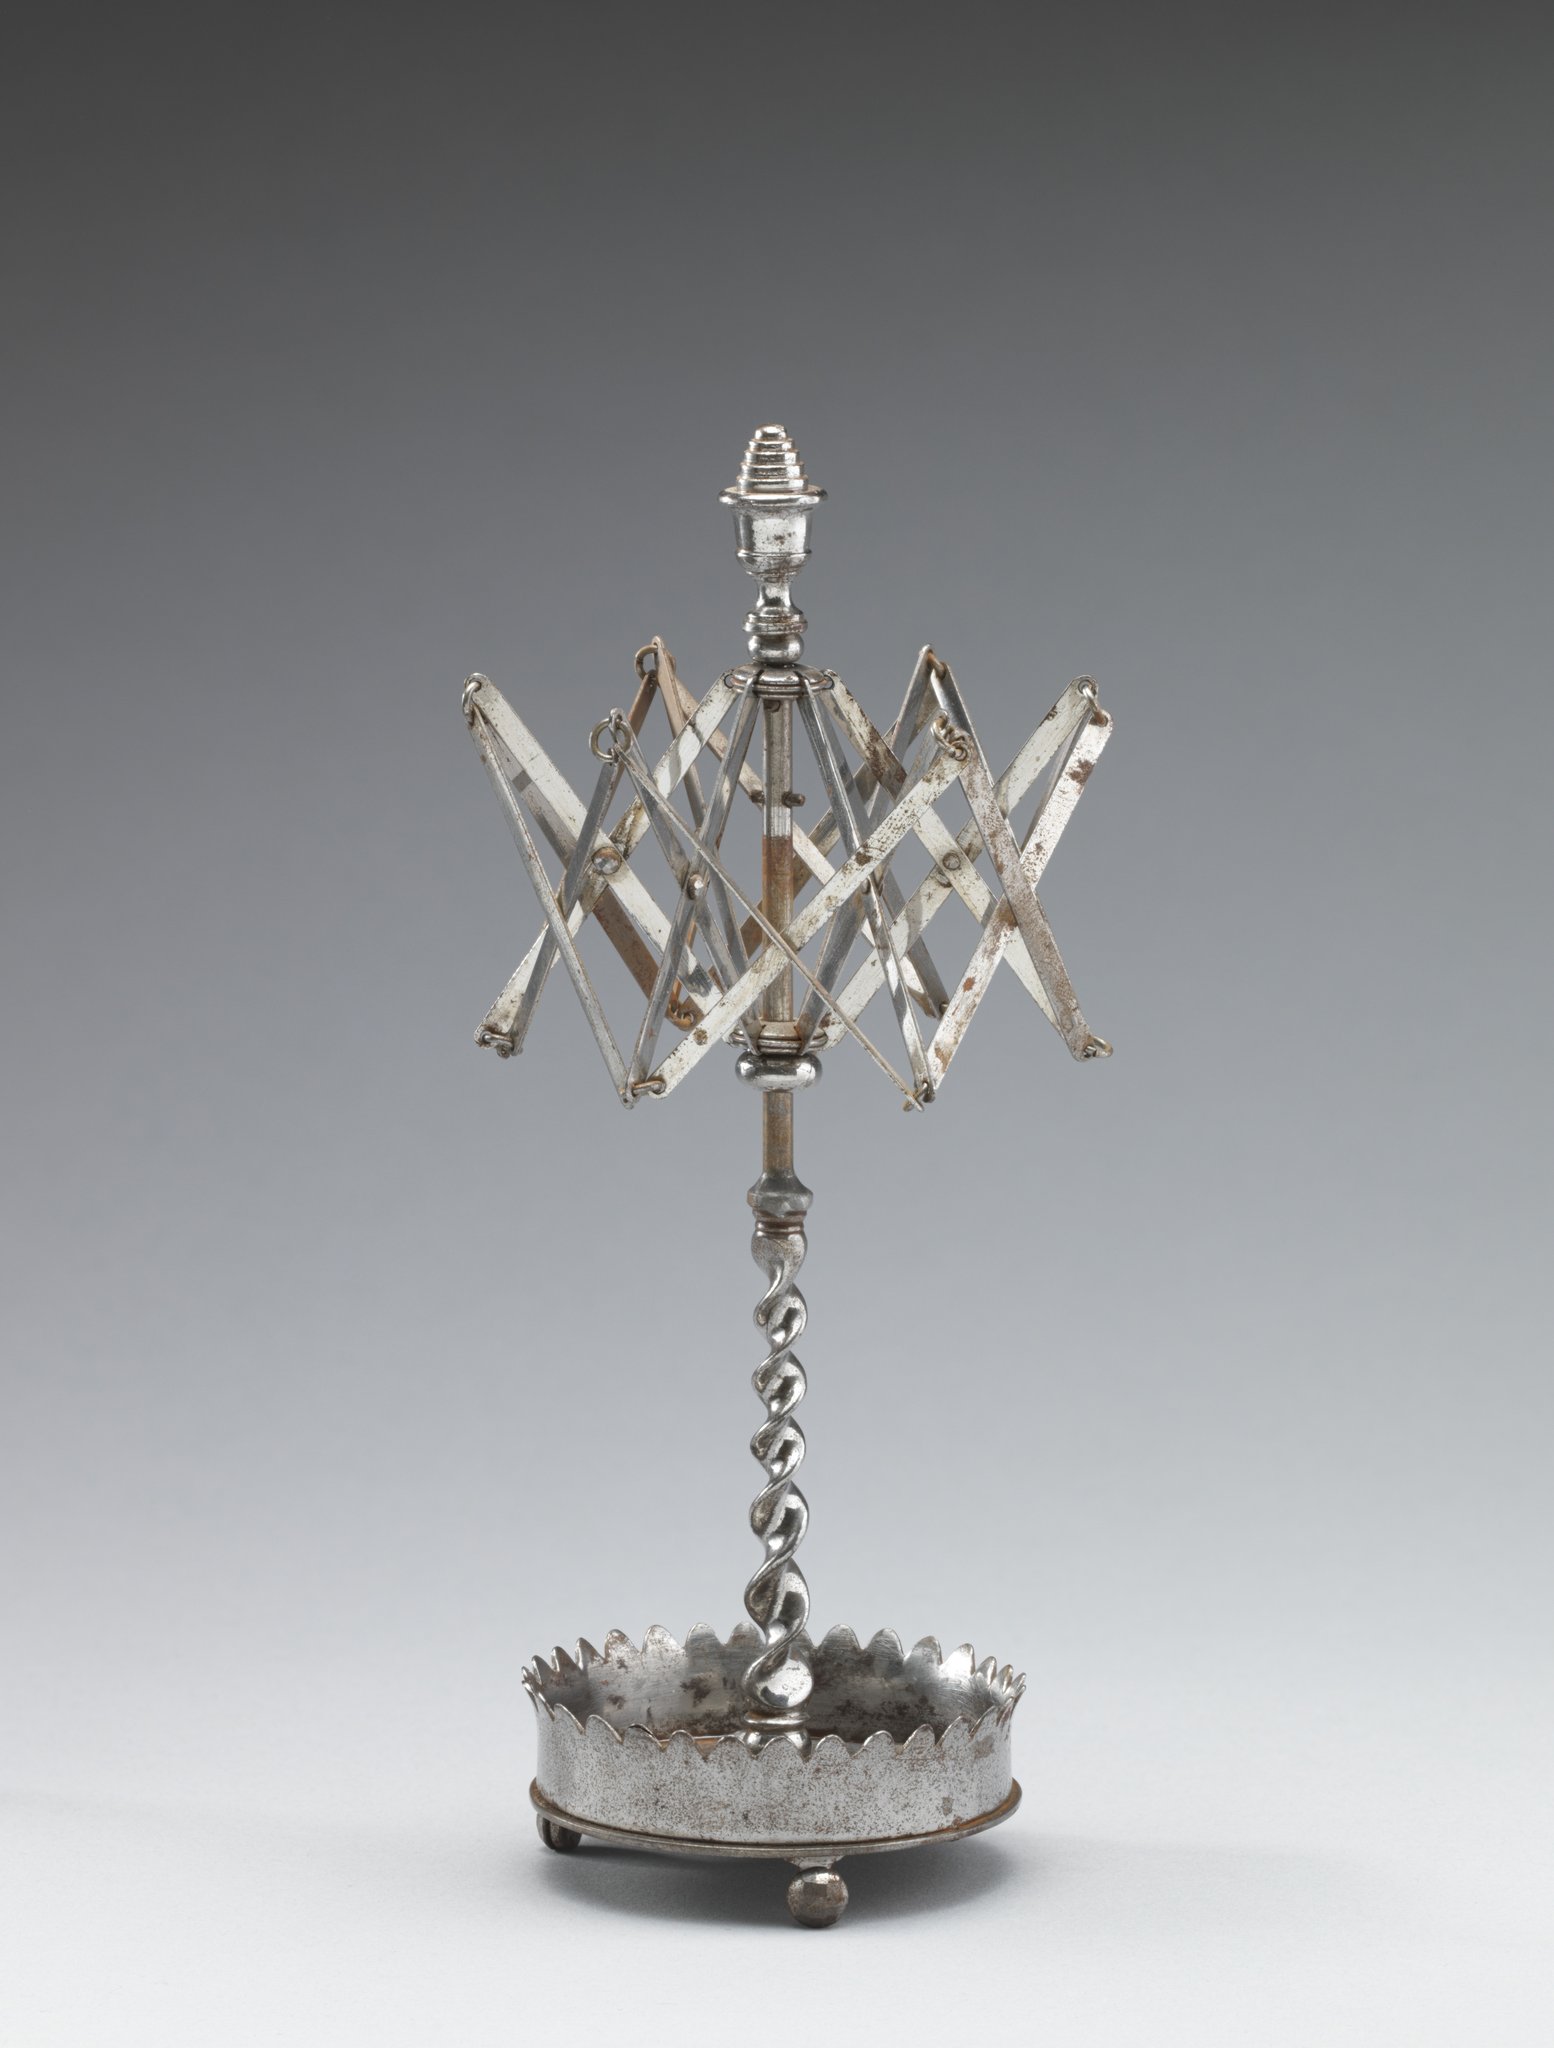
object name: thread winder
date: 1801-1833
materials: steel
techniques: cutting